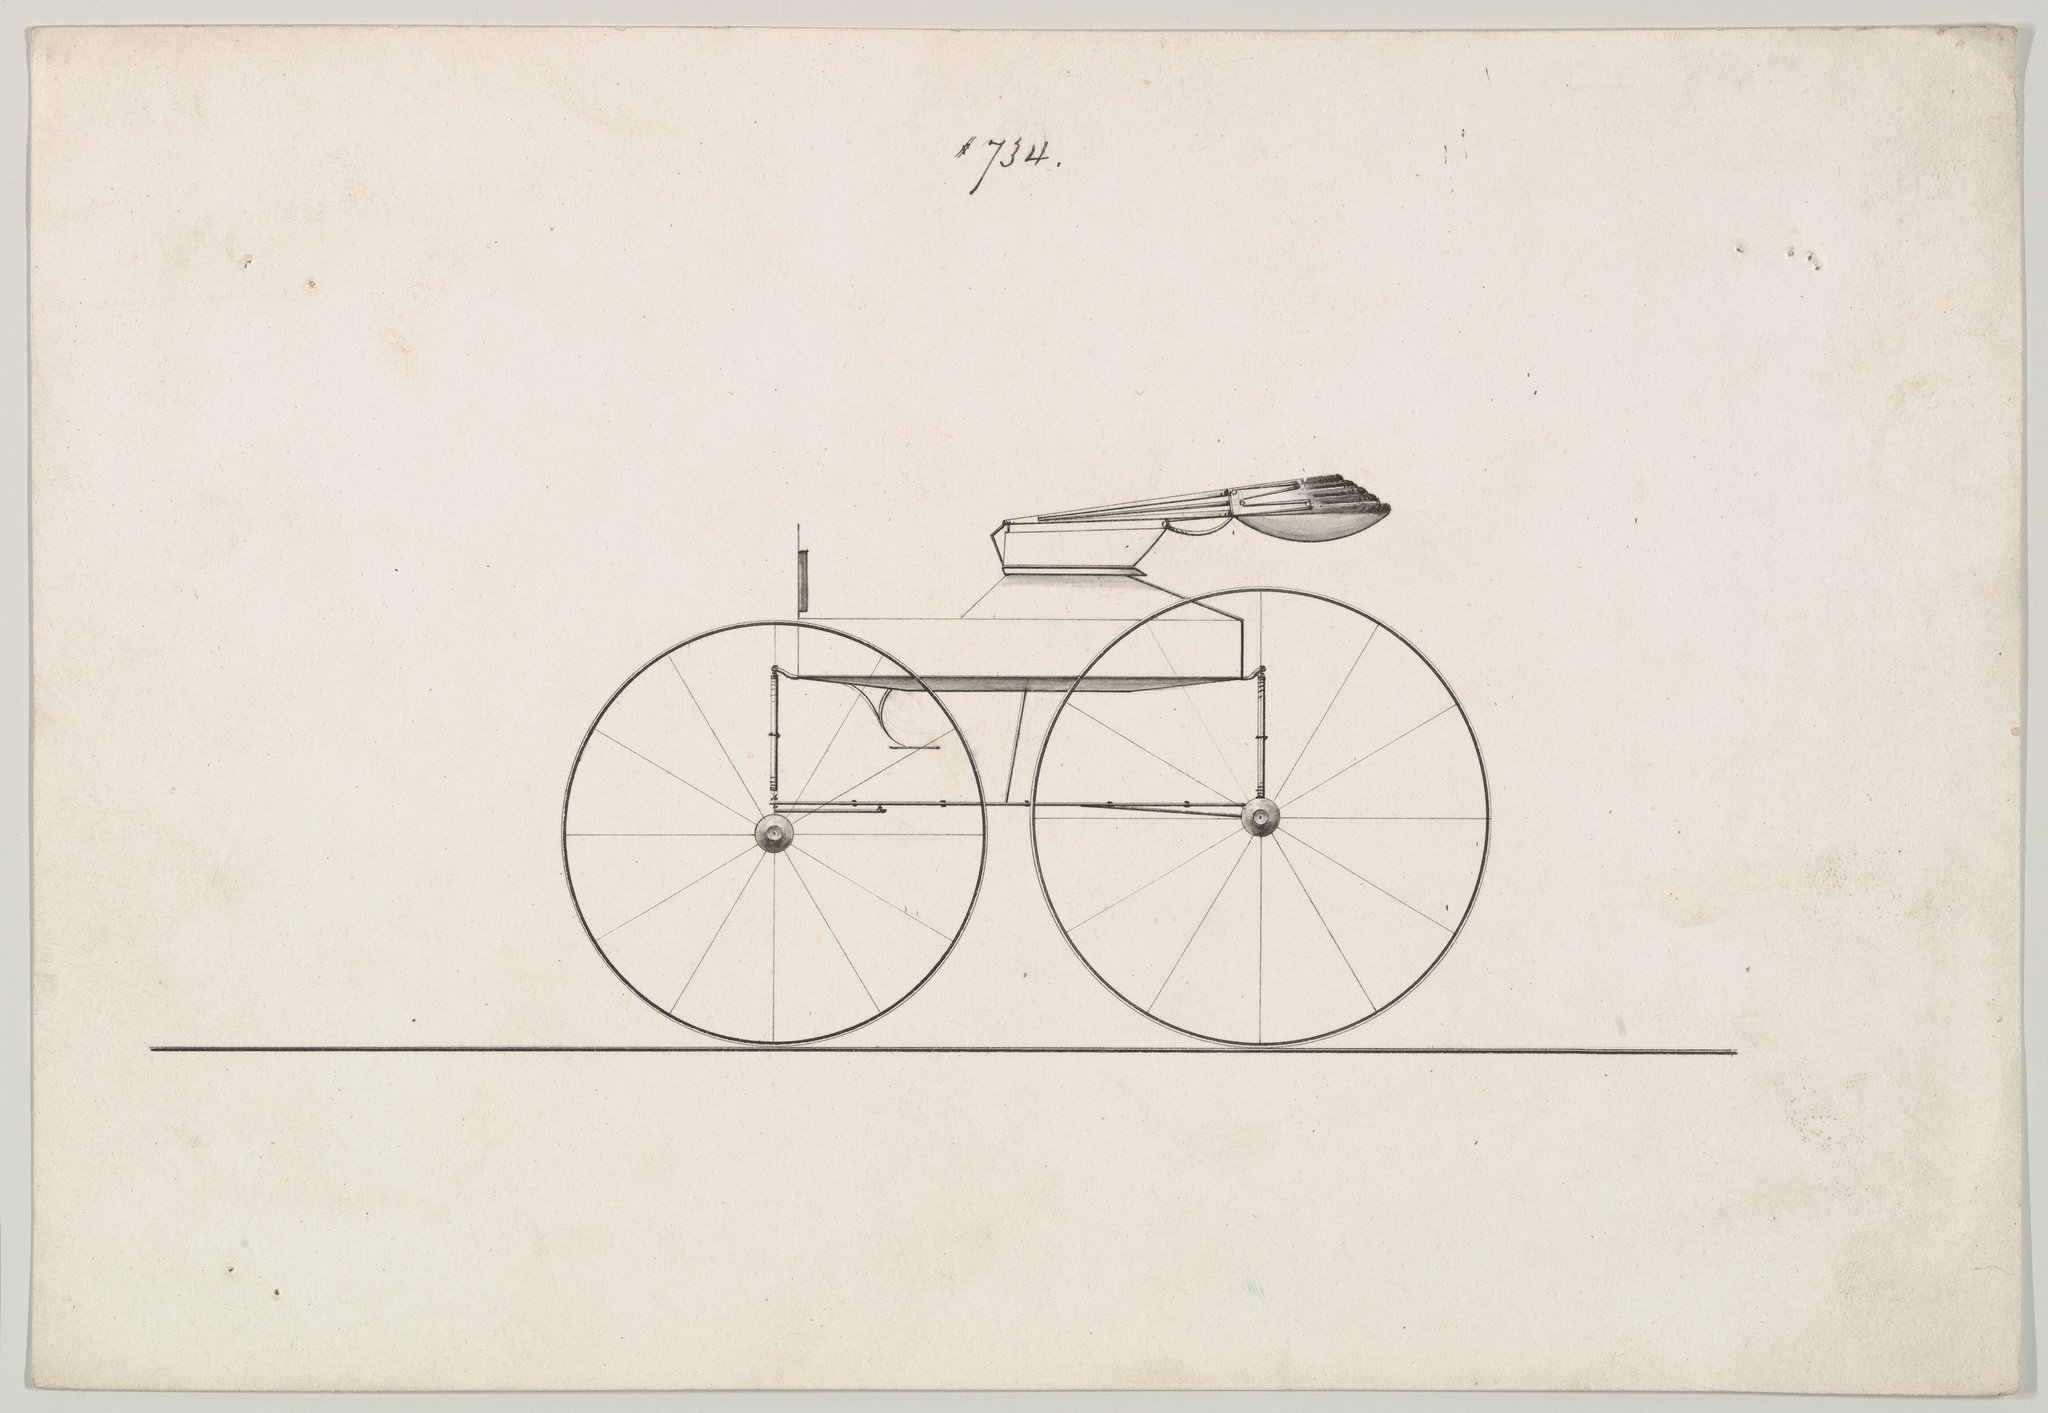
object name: drawing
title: Design for Wagon, no. 734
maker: brewster & co.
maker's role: manufacturer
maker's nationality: american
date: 1860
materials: ink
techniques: pen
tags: carriages